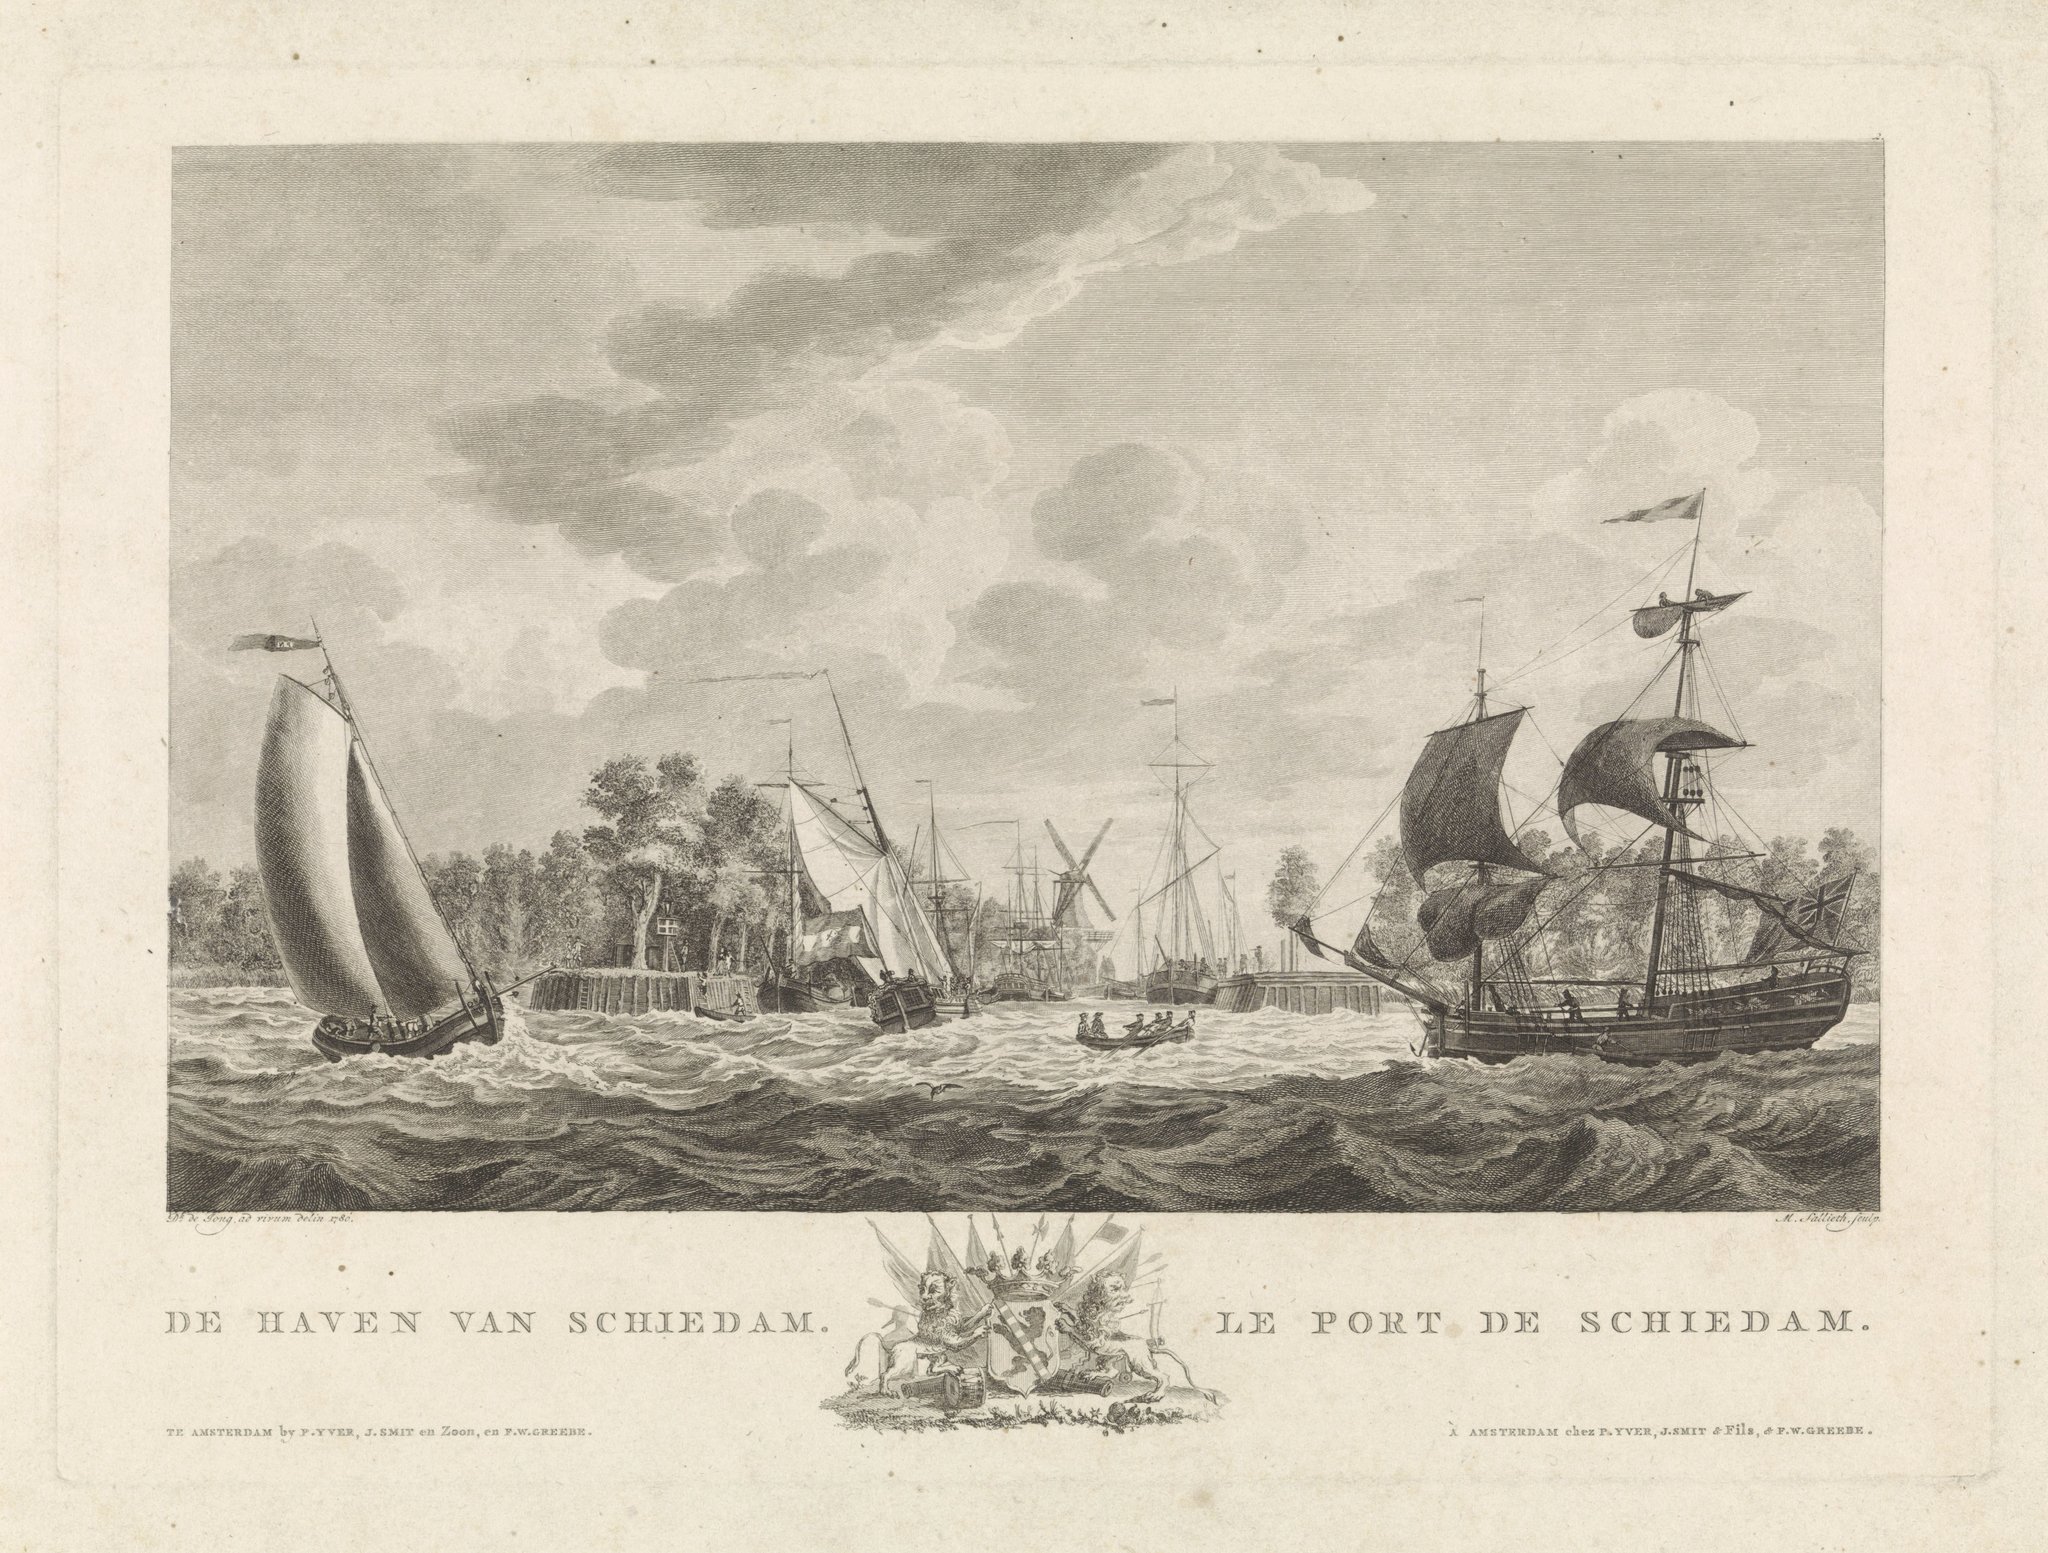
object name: print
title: Gezicht op de haven van Schiedam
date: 1780-1787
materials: paper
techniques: etching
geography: amsterdam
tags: harbour, coat of arms (as symbol of the state, etc.) (+ city; municipal), sailing-ship, sailing-boat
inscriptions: collector's mark: Lugt 2228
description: Latere staat ook gebruikt in: Aa, Cornelis van der. Atlas van de zeehavens der Bataafsche Republiek. Met derzelver beschrijvingen in XXXI kunstplaaten / Atlas van de zeehavens der Bataafsche Republiek, die van Batavia en Onrust. Mitsgaders de afbeeldingen van de haringvisscherij en de walvischvangst […]. Amsterdam: Evert Maaskamp, 1805.